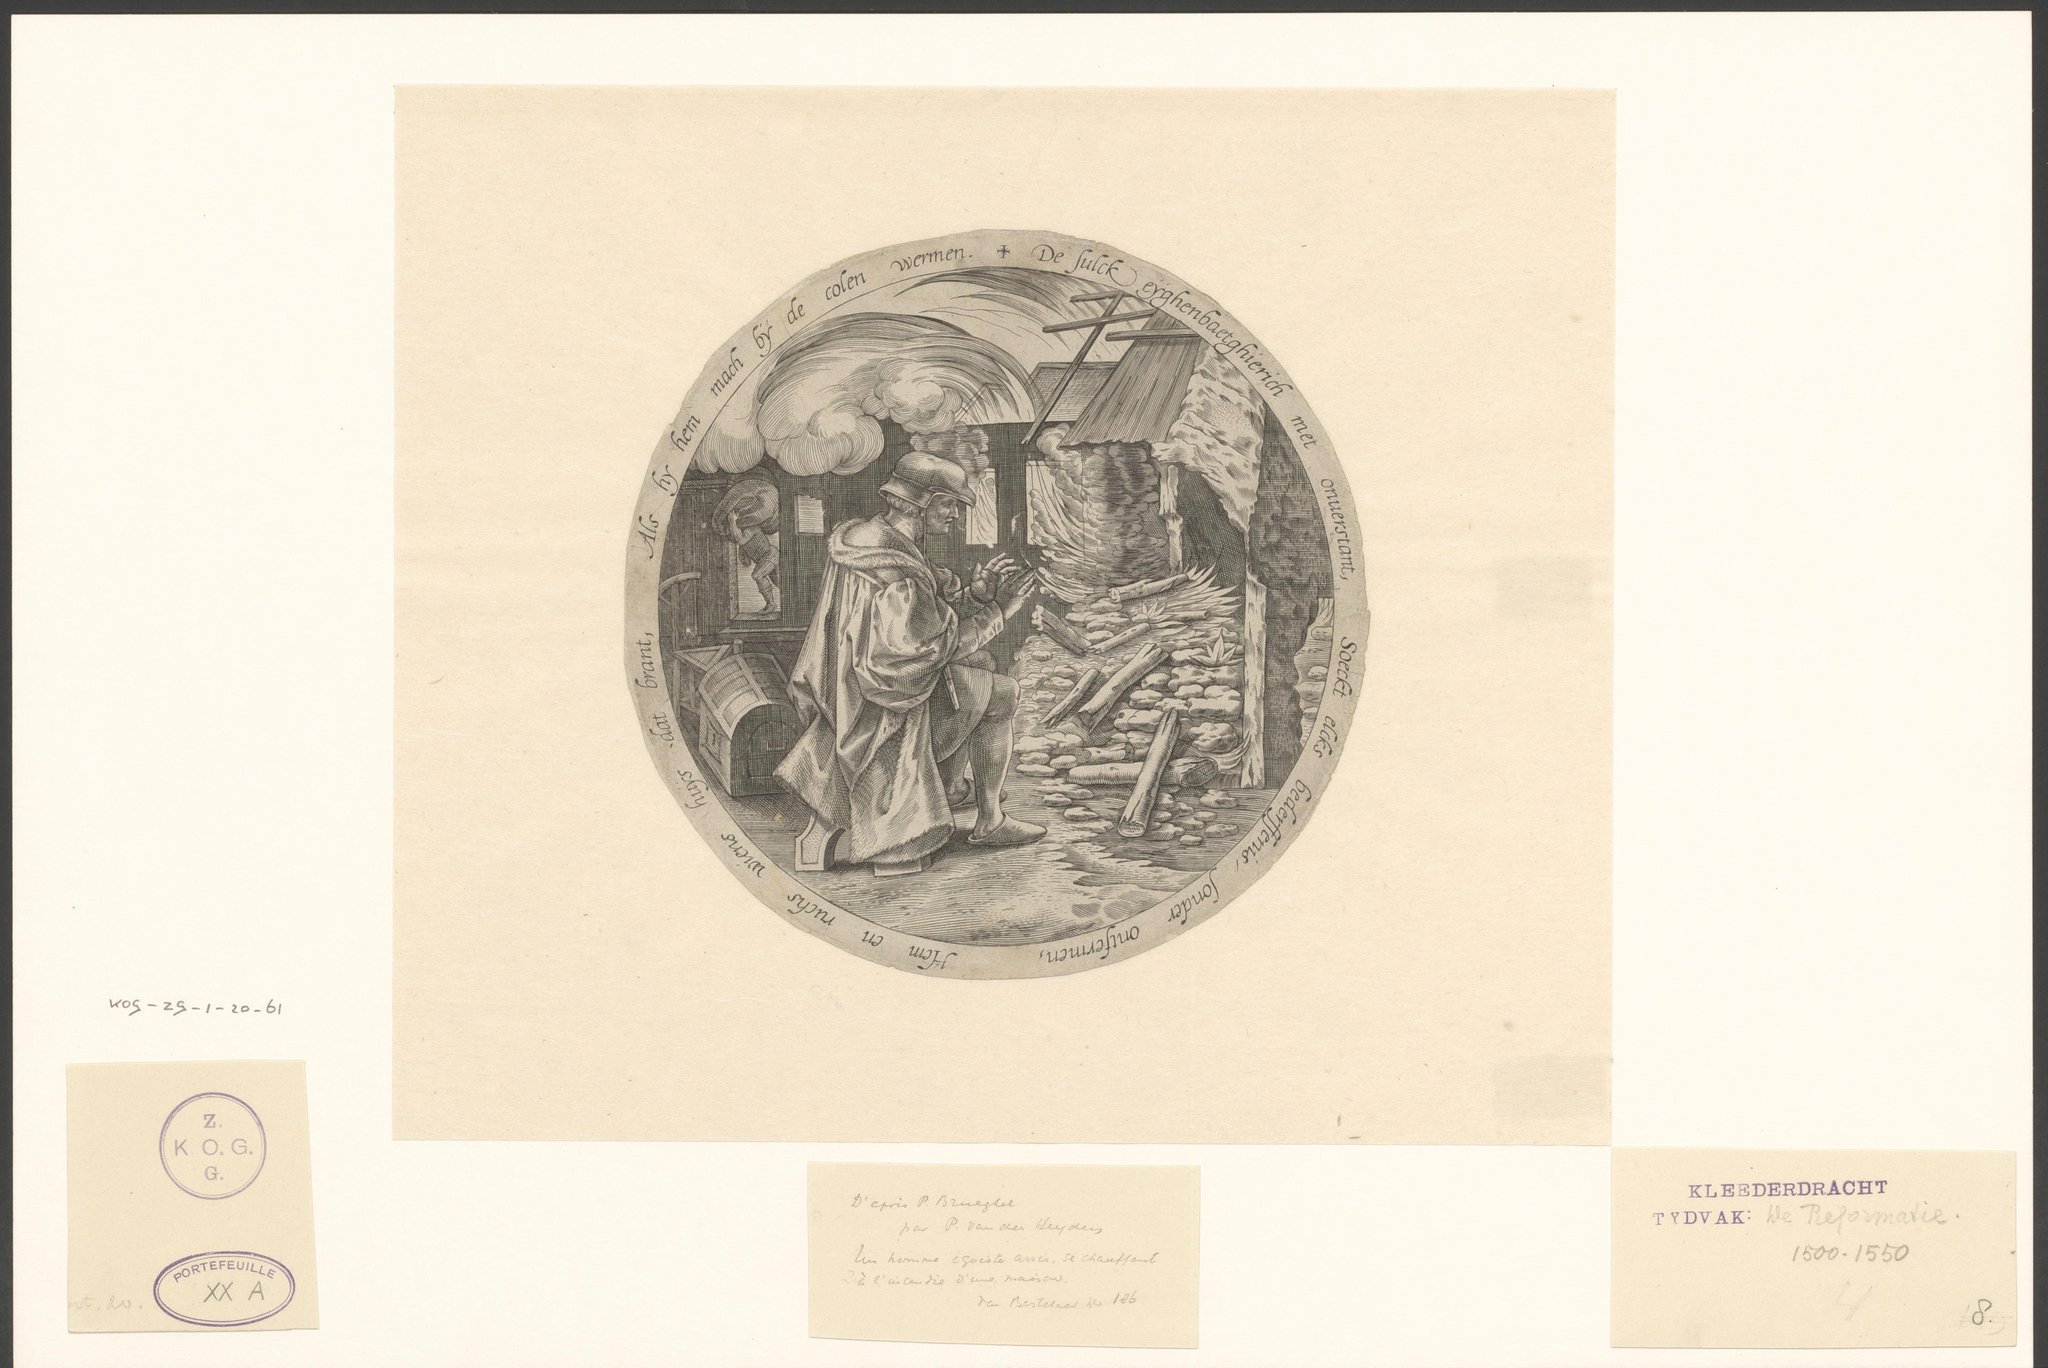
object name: print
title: Egoïst warmt zichzelf aan een brandend huis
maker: pieter van der heyden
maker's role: print maker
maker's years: 1520-1582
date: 1551-1572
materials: paper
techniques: engraving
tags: on fire, ablaze, selfishness; 'interesse', 'interesse proprio' (ripa)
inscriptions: collector's mark: Lugt 1641, stamp, stamp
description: Egoïst warmt zichzelf aan een brandend huis. Het maakt hem niet uit dat iemand anders huis afbrandt. Onderwerpsrubrieken binnen de Atlas Zeden en Gewoonten: Zeden en Gewoonten in Engeren Zin, De Kleeding, Kleederdrachten (tijdvakken), De Reformatie. (1500 – 1550).